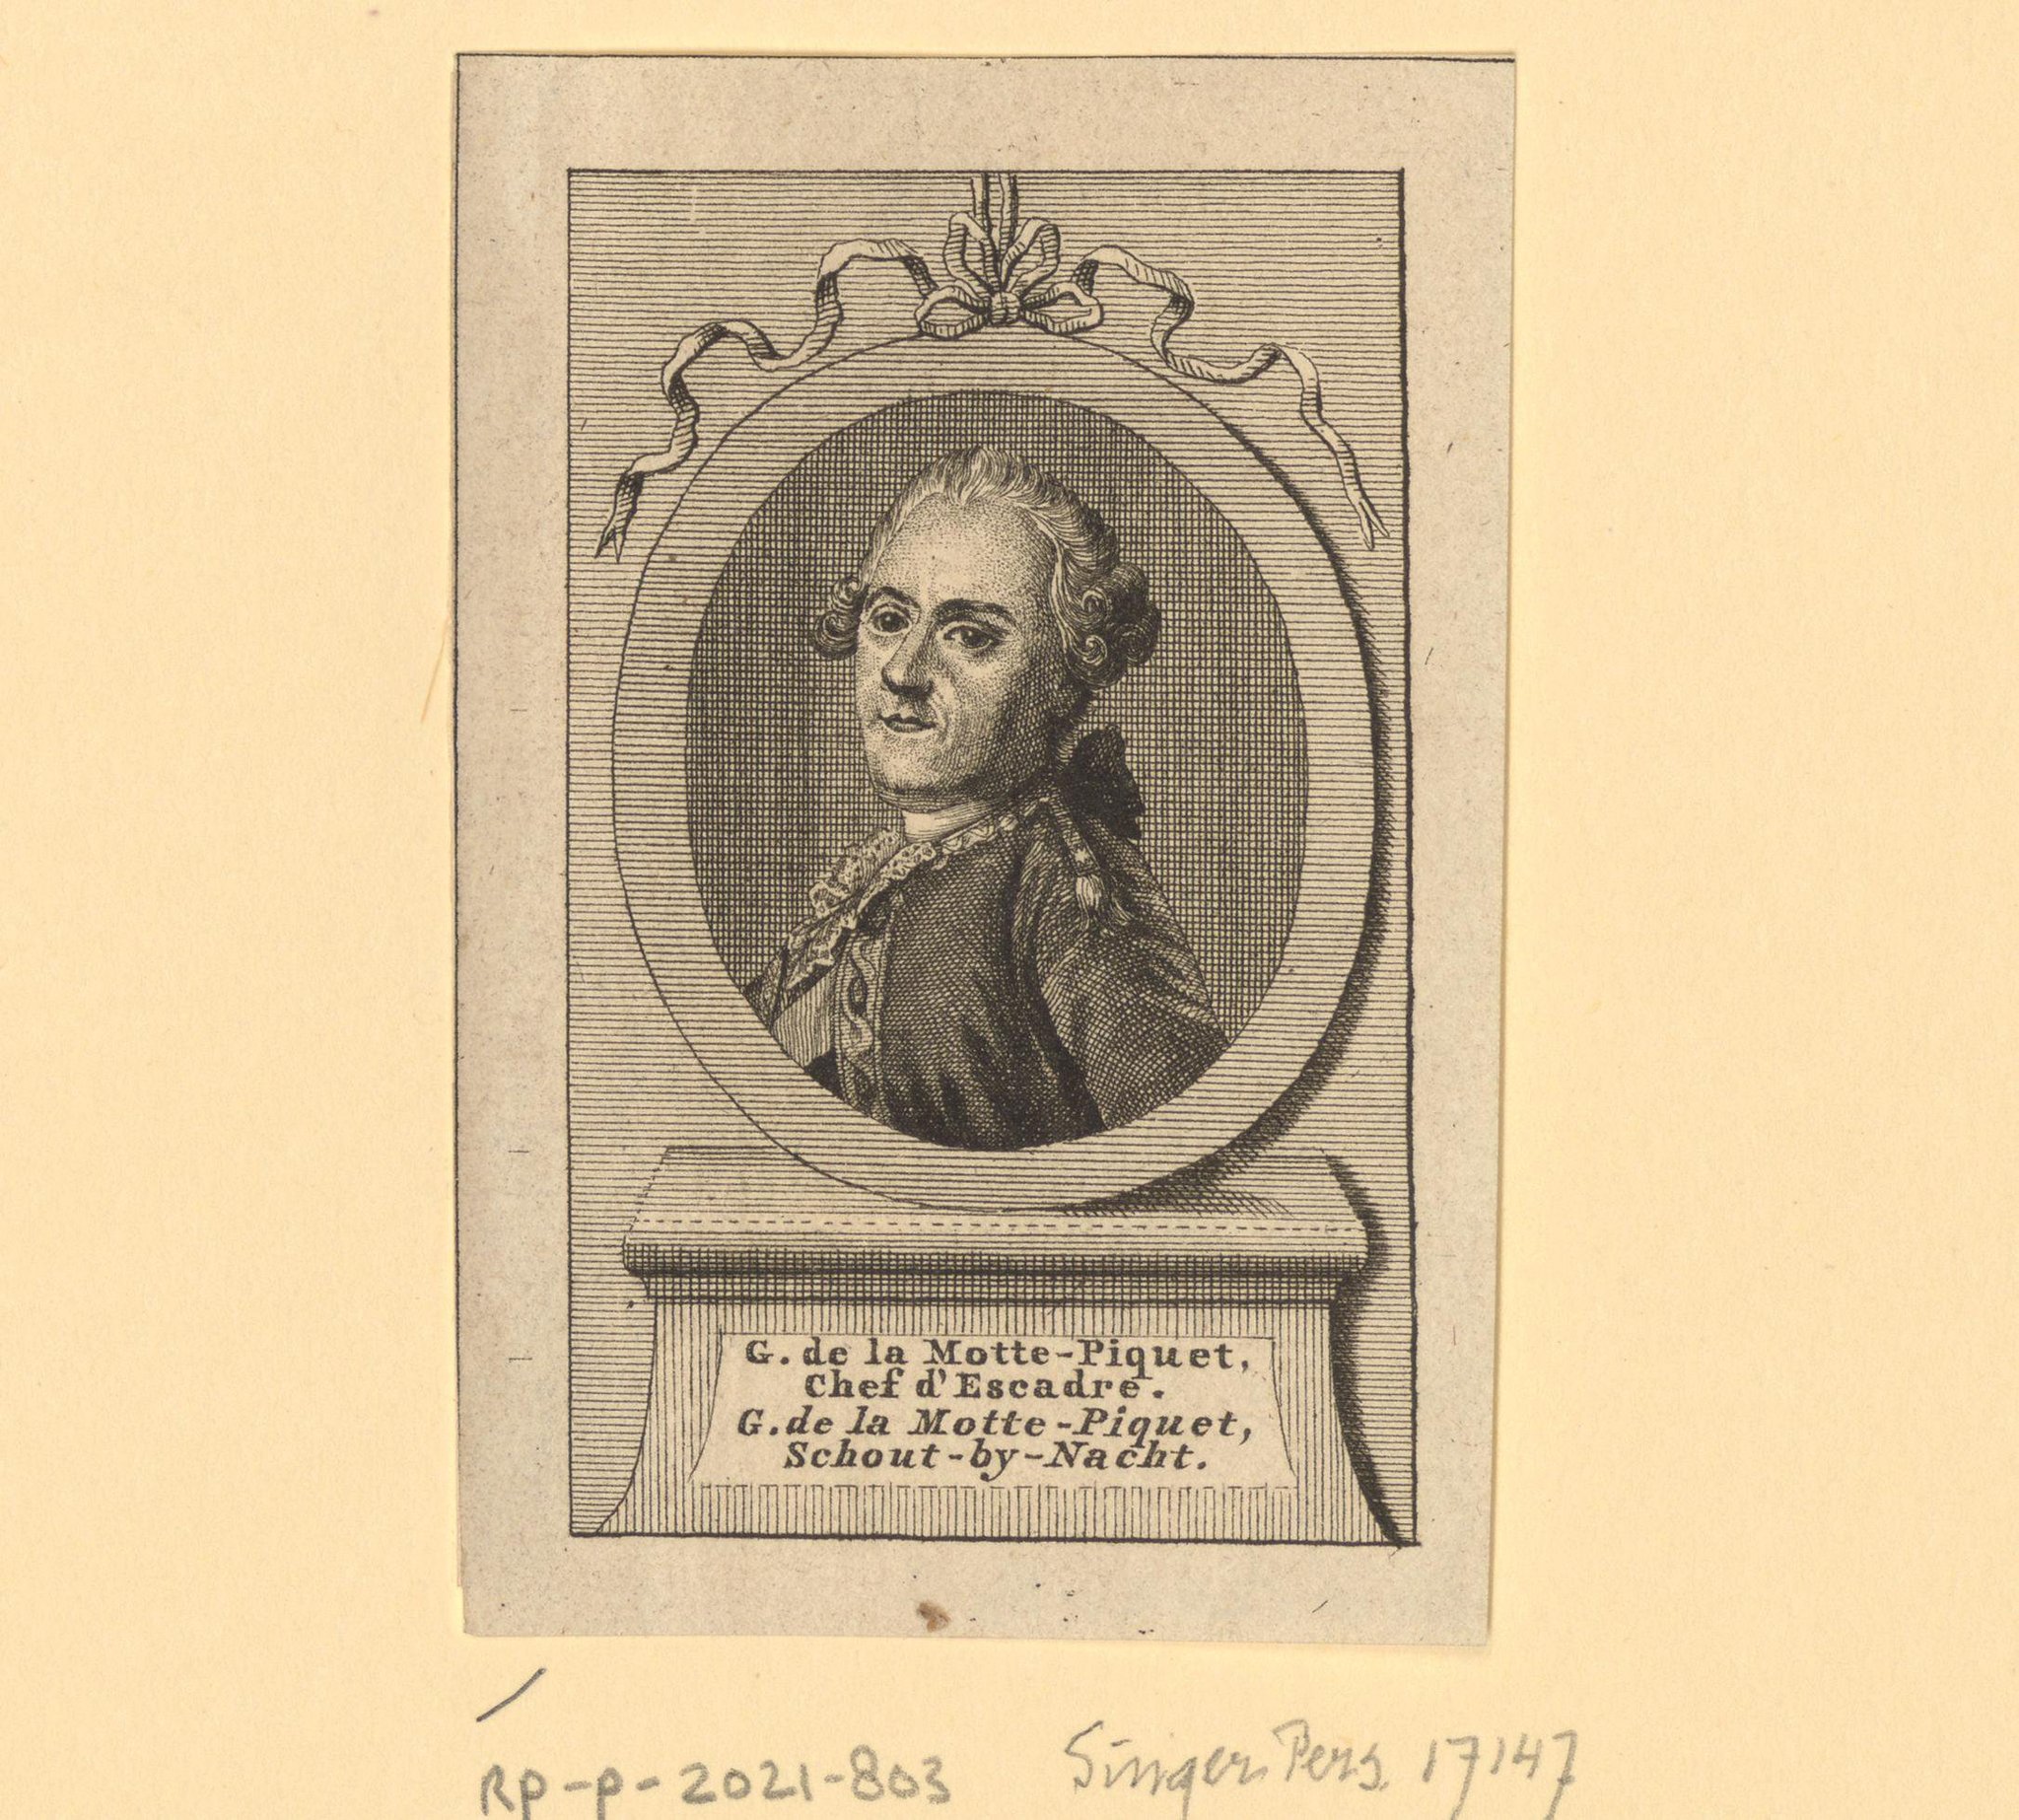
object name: print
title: Portret van Toussaint-Guillaume Picquet de la Motte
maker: Anonymous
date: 1783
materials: paper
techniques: etching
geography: northern netherlands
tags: historical persons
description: Prent waarschijnlijk uit: De nuttige en aangenaame staatsalmanach, voor het jaar MDCCLXXXIII (...). Amsterdam: T. en J.A. Crajenschot, 1783.